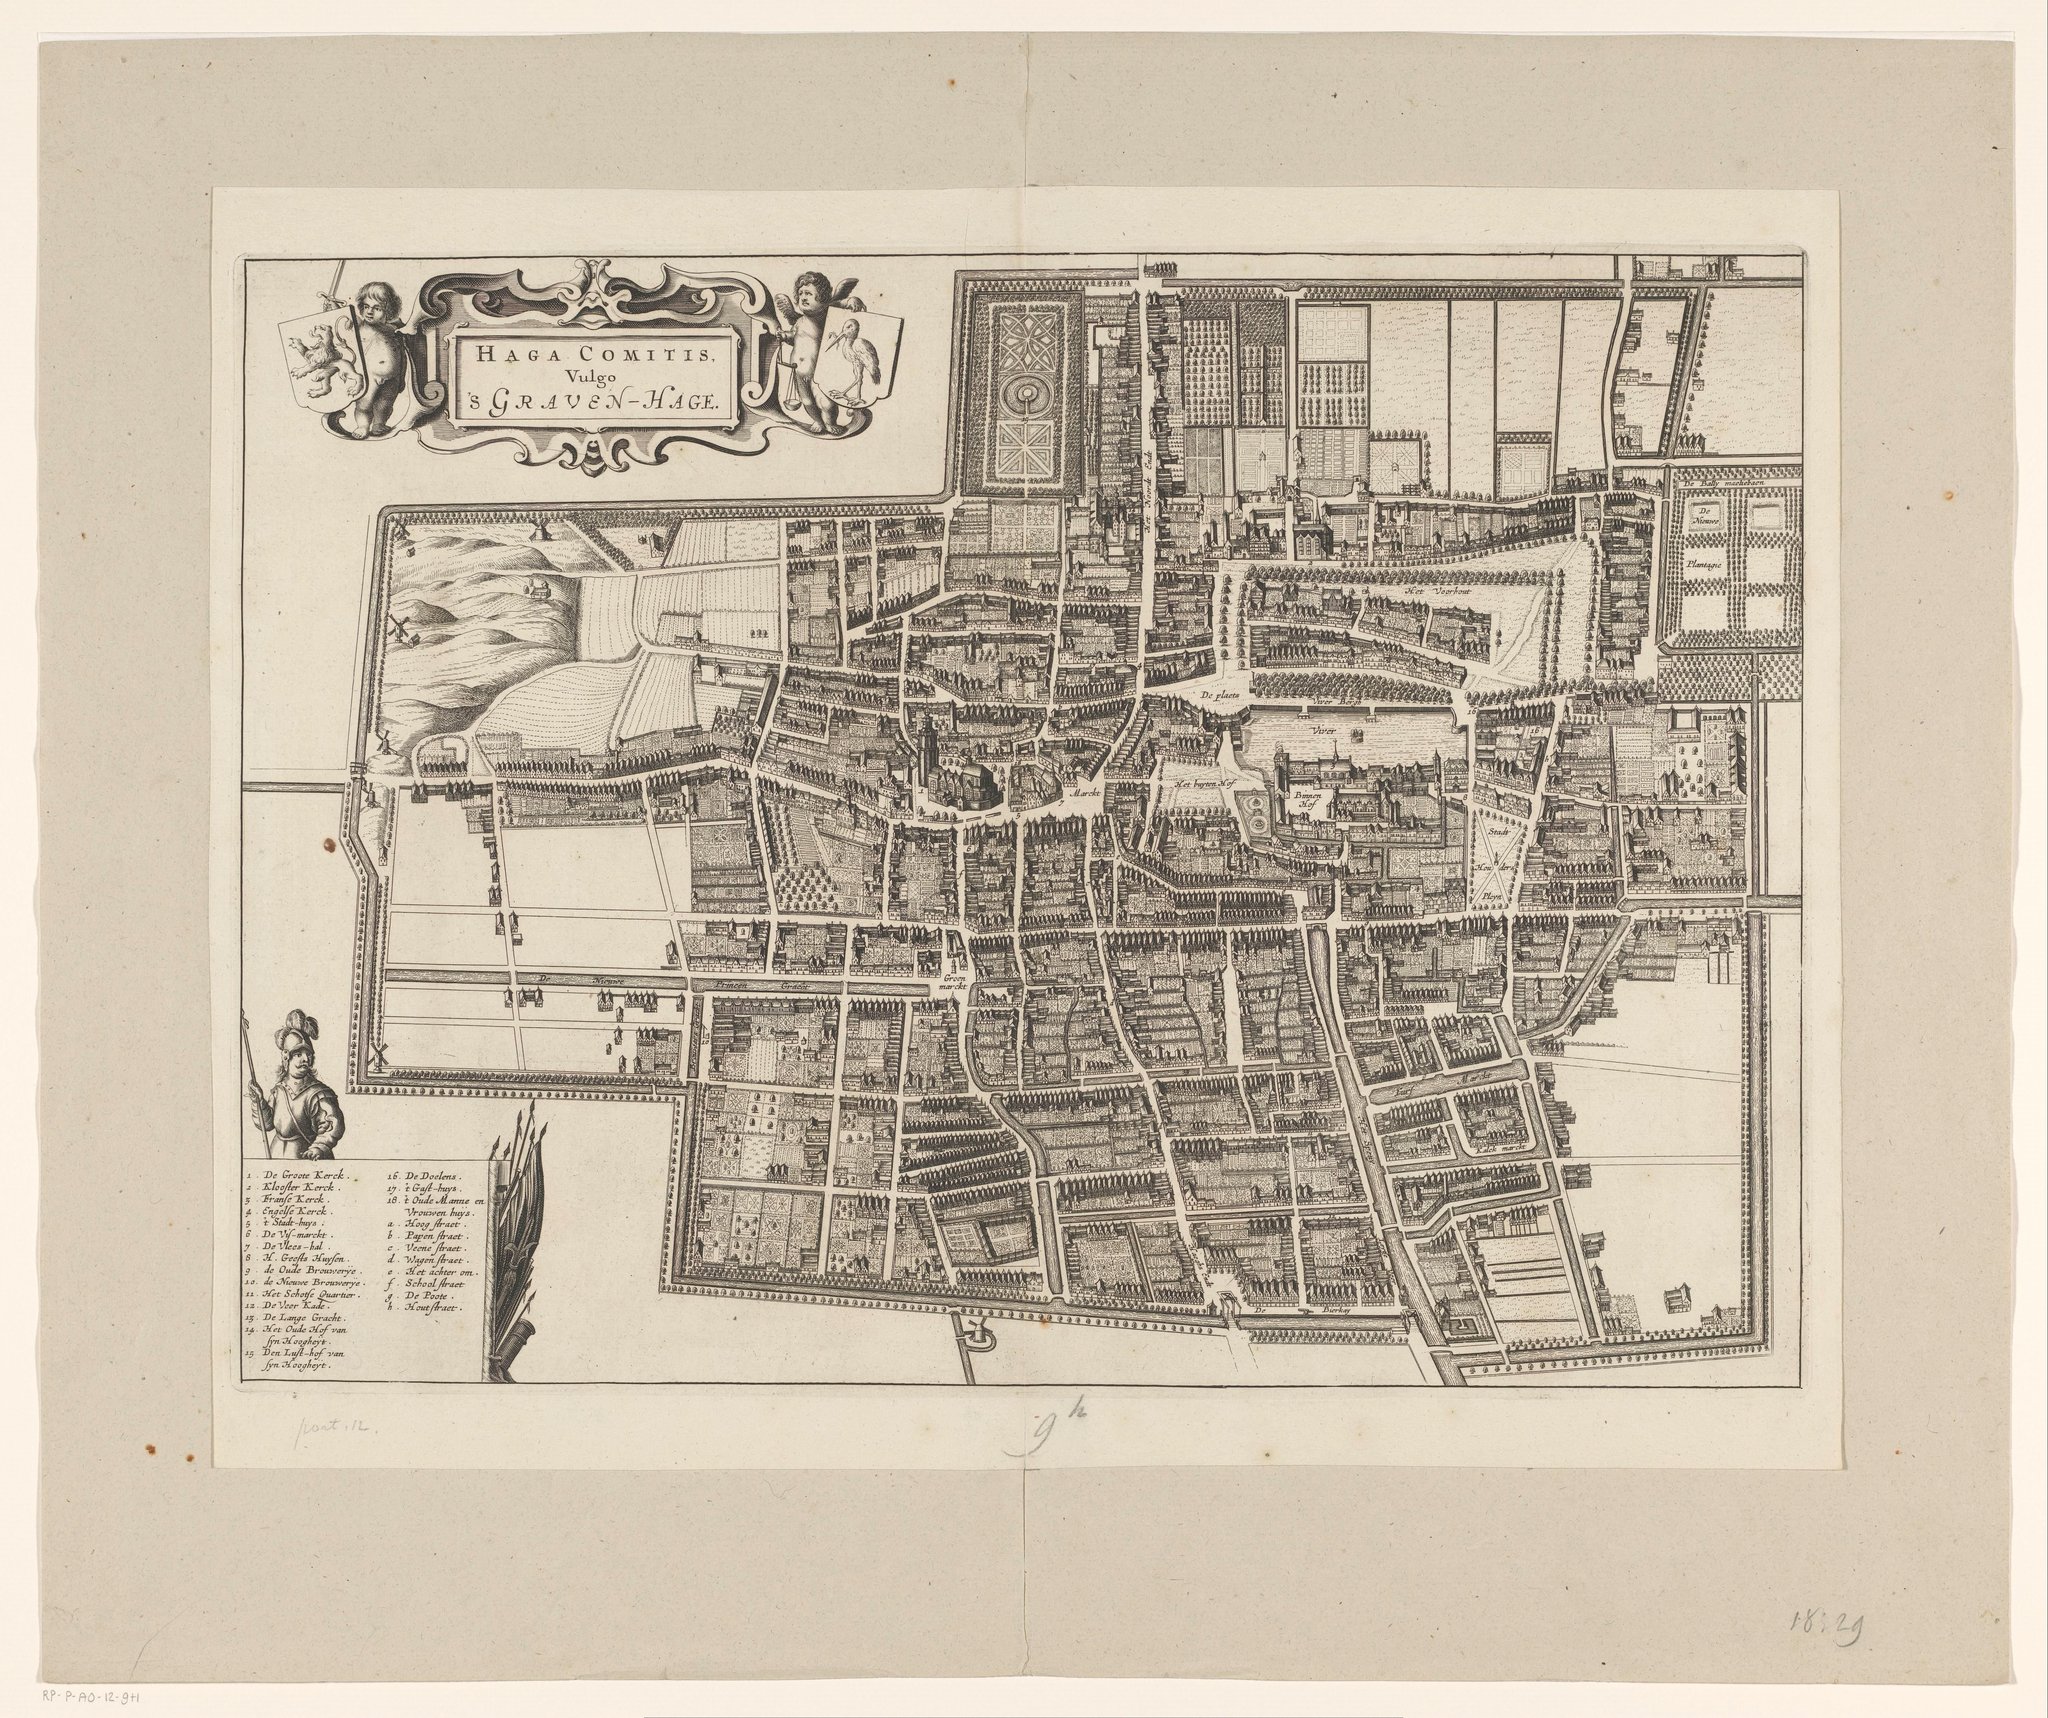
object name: area plan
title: Plattegrond van Den Haag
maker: Anonymous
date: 1657-1690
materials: paper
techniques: engraving, etching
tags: coat of arms (as symbol of the state, etc.) (+ city; municipal), maps of cities, coat of arms (as symbol of the state, etc.) (+ province; provincial), the hague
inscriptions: collector's mark: Lugt 2228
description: Deze staat van prent met tekst op verso ook gebruikt in: Theatrum Urbium Celebriorum totius Belgii sive Germaniae Inferioris. 2 delen. Amsterdam: Johannes Janssonius, 1657, dl. 2. Zonder tekst op verso (zoals het huidige exemplaar) is deze staat van prent ook gebruikt in: Tooneel der vermaarste koop-steden en handelsplaatsen van de geheele wereld. 2 delen. Amsterdam: erven Johannes Janssonius van Waesberge (I) / Johannes Janssonius van Waesberge (II), 1682, dl. 1. En in: Plans des principales cités de l'Univers. Amsterdam: Dancker Danckerts, ca. 1658. En in: Leti, Gregorio. Teatro Belgico o vero ritratti historici, chronologici, politici e geografici delle Sette Provincie Unite. 2 delen. Amsterdam: Willem de Jonge, 1690, dl. 2.